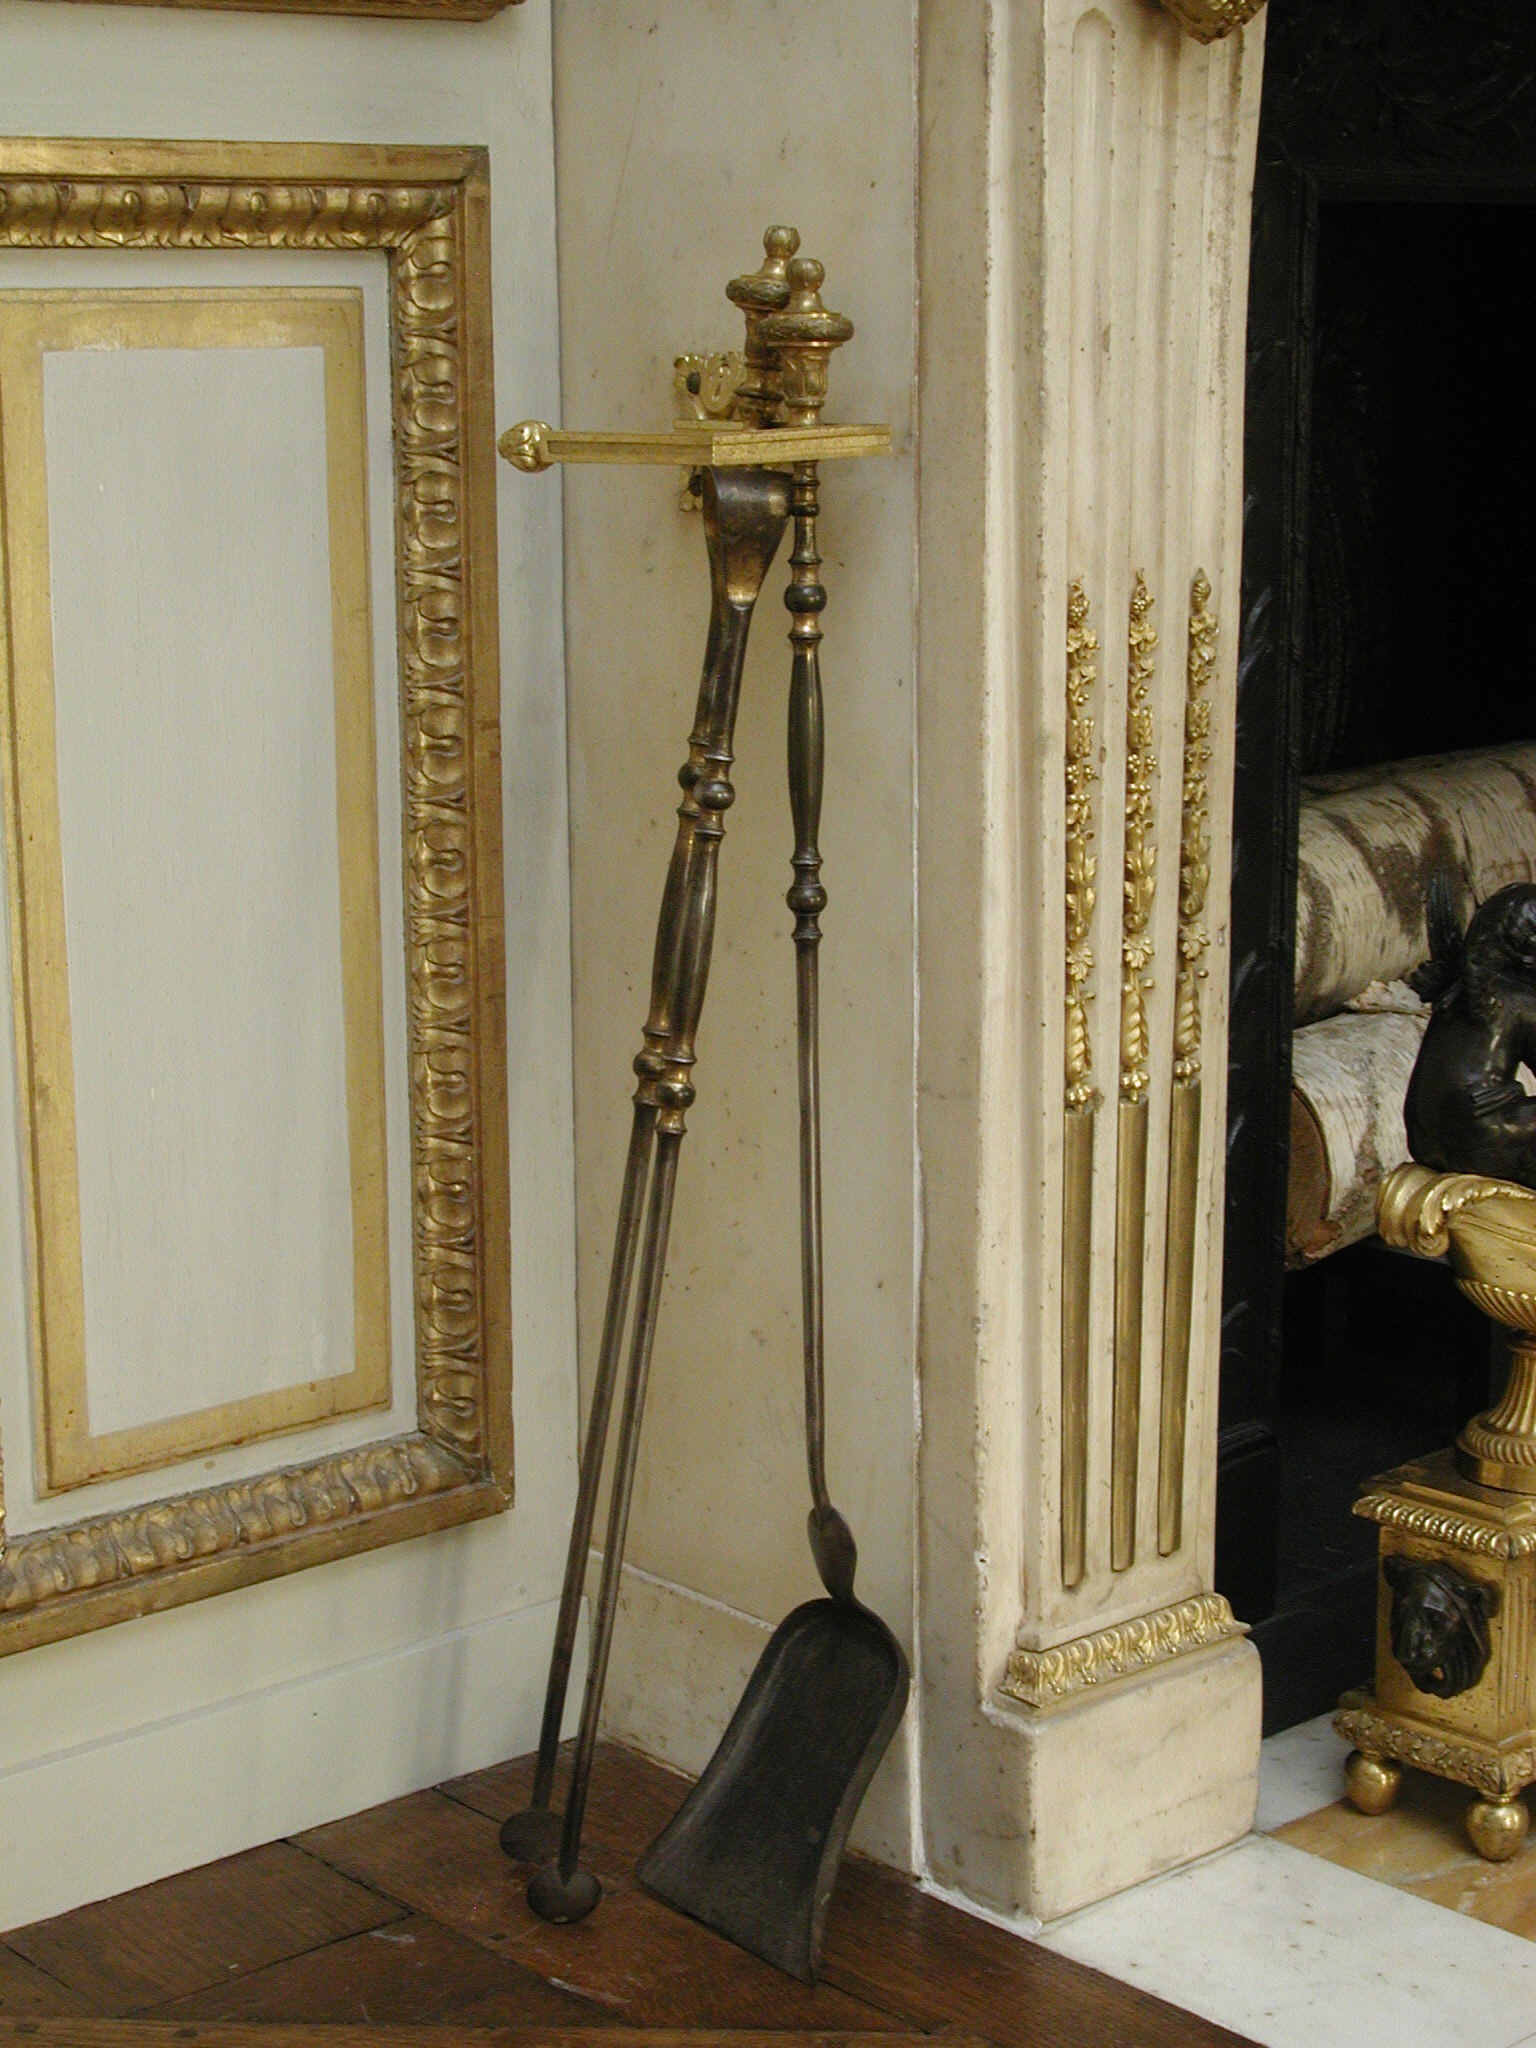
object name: fire iron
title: Fire-irons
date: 1770-1790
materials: gilt bronze, steel